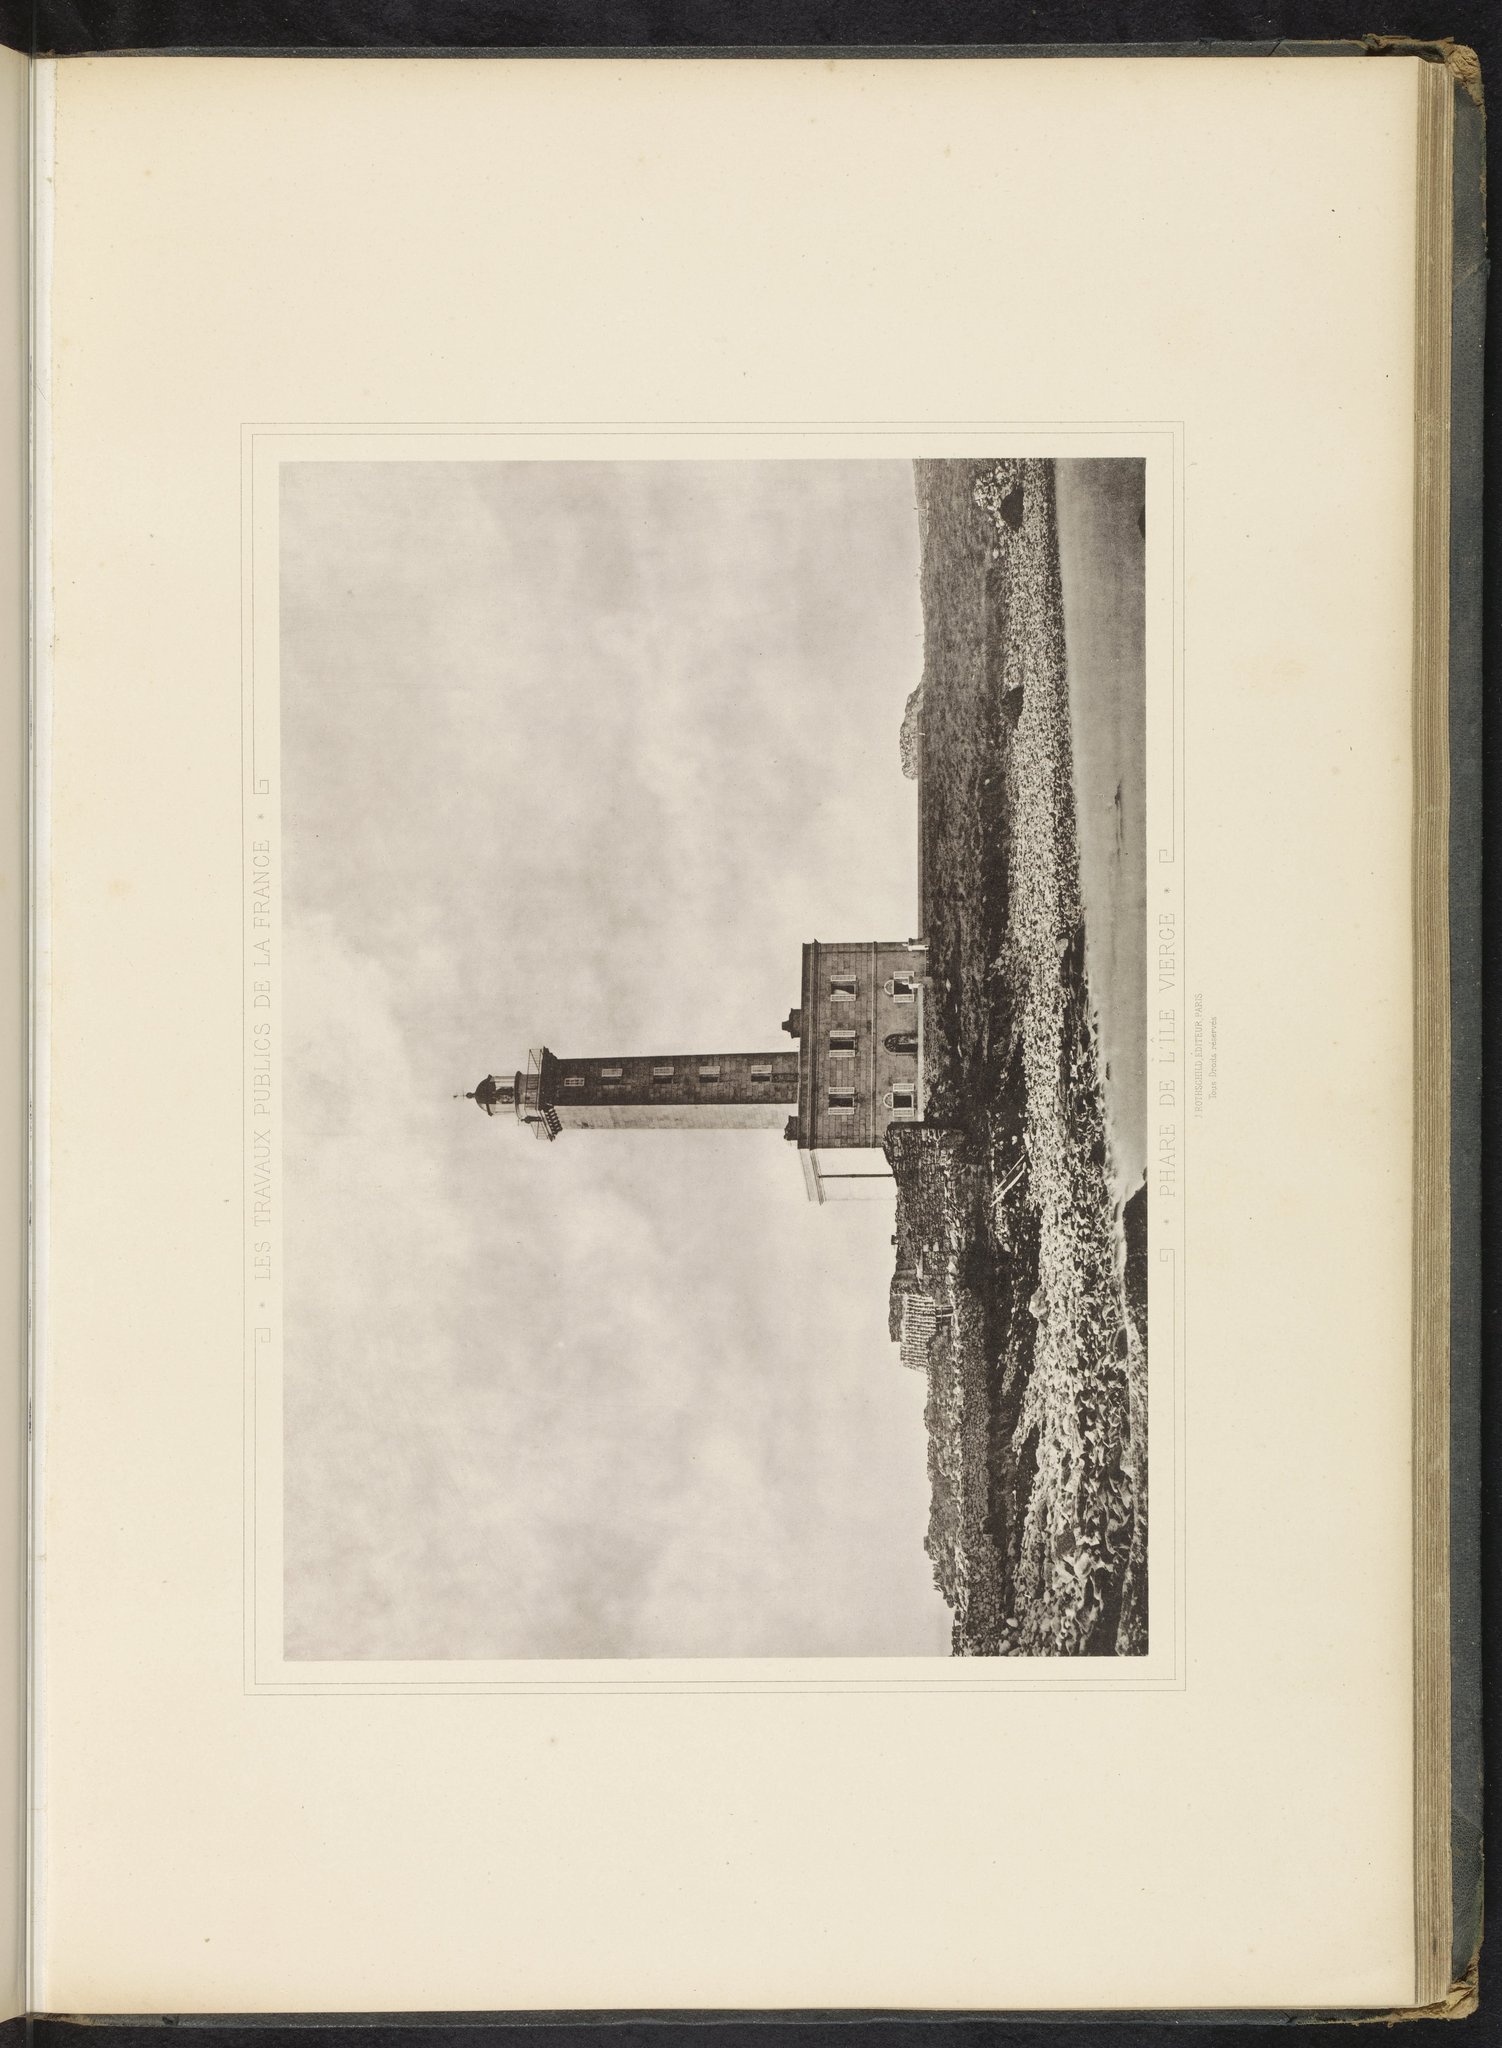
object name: photomechanical print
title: Phare de l'Île Vierge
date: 1873-1883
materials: paper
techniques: photograph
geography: paris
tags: lighthouse, lightship, island, rocky coast